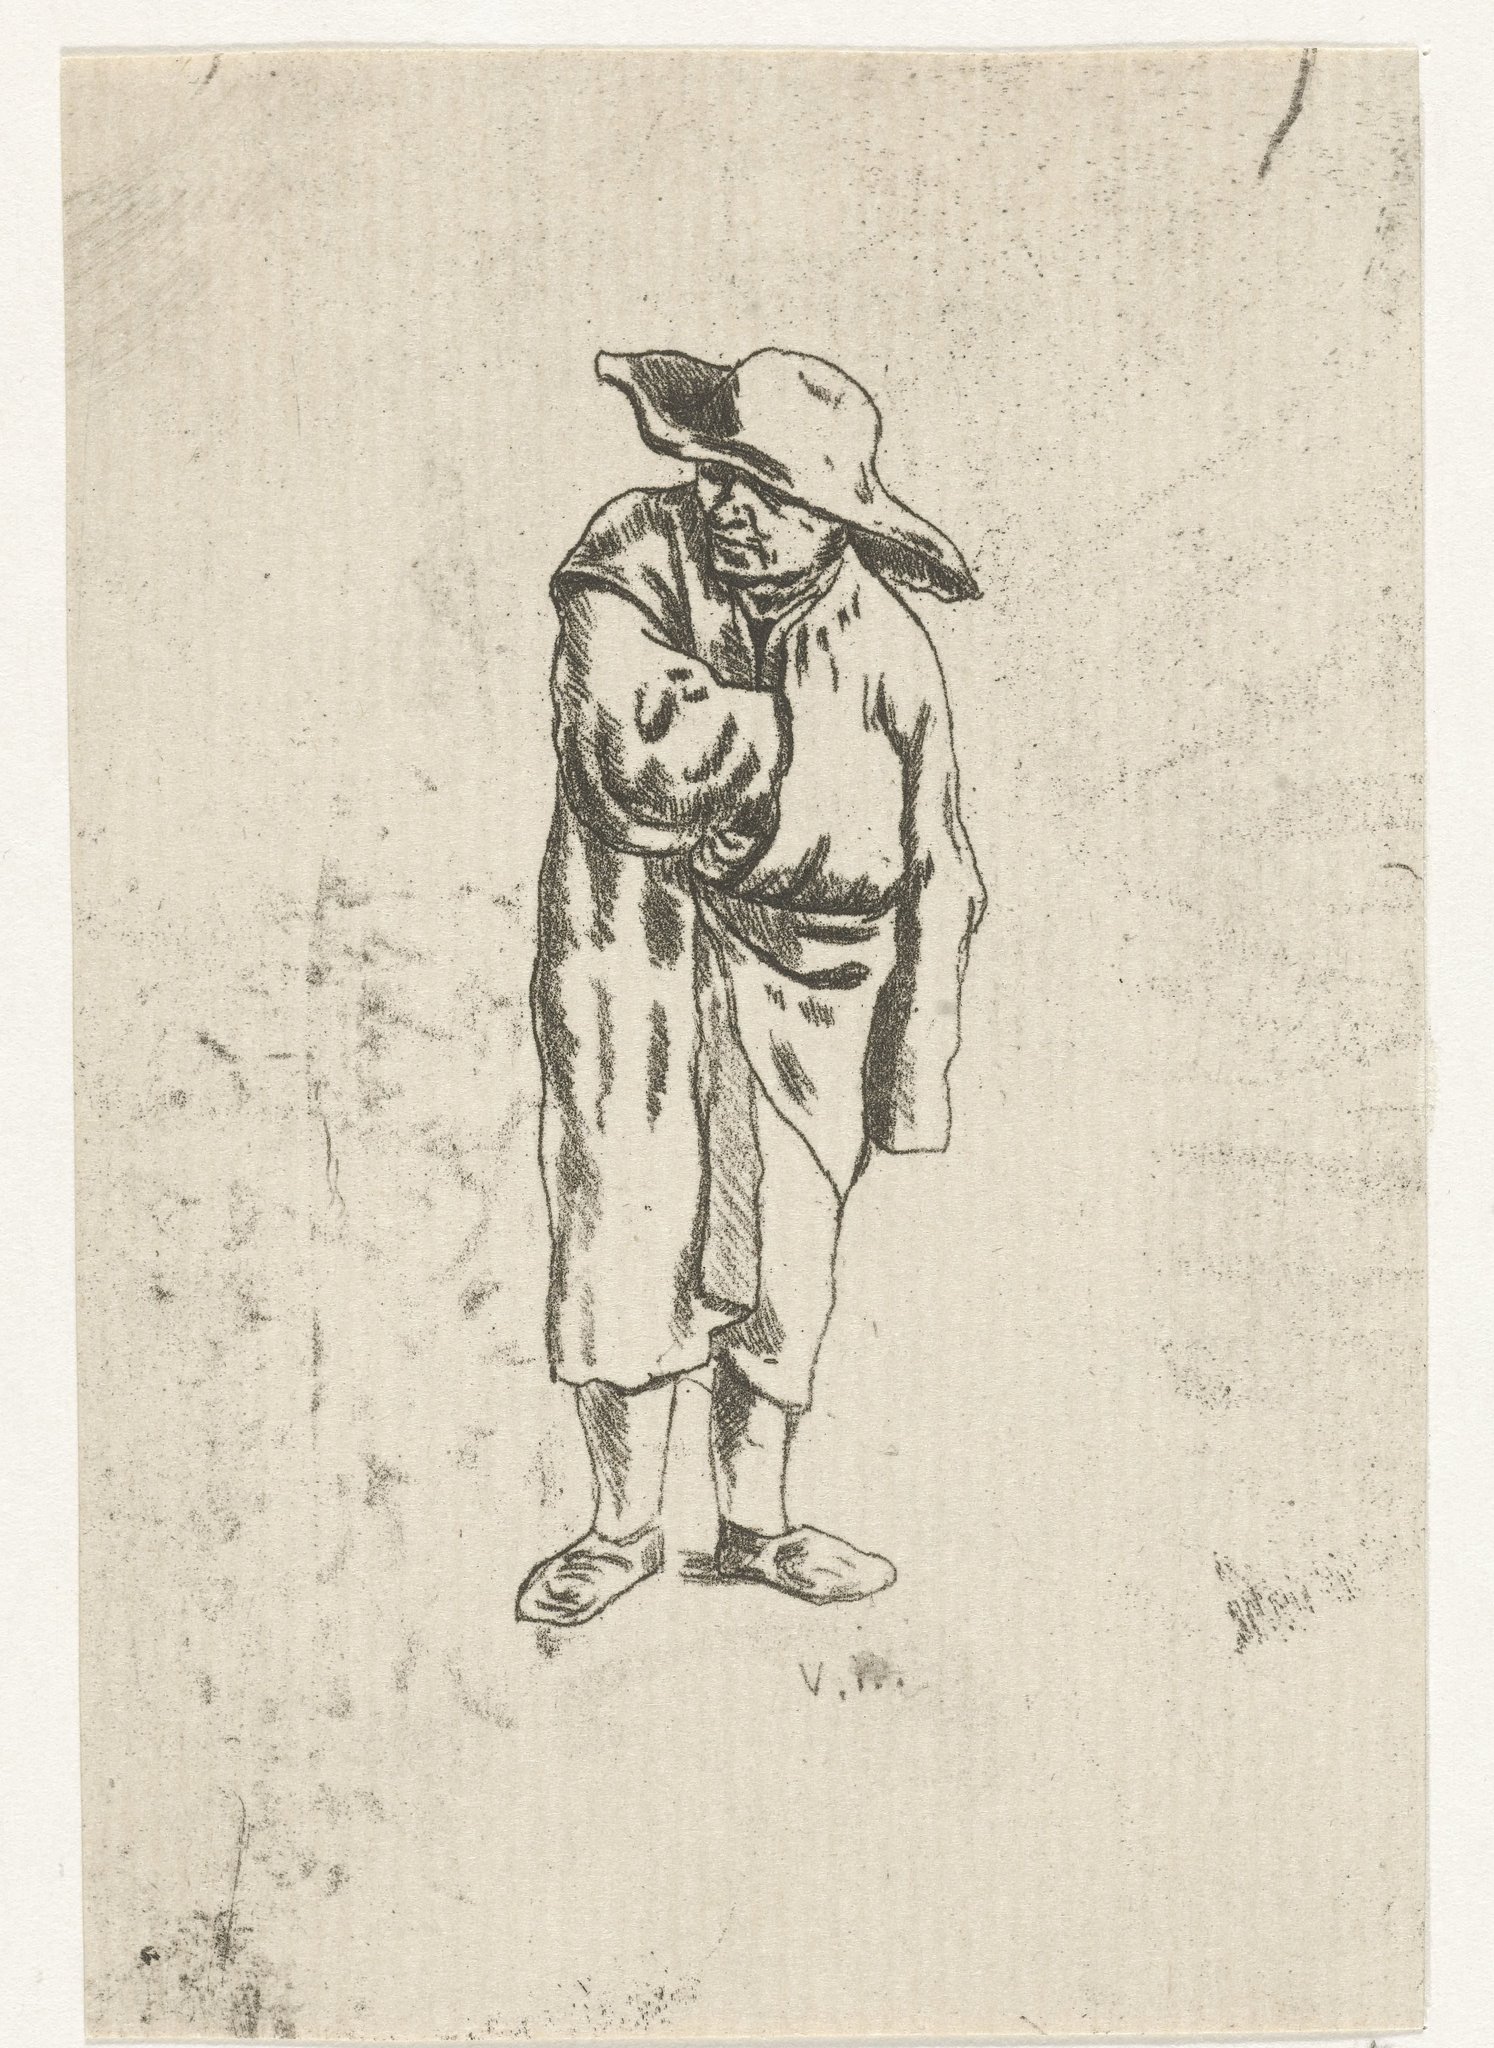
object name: print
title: Man met arm in zijn jas gestoken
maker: nicolaas gerhard van huffel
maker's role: print maker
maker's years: 1869-1936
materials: paper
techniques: soft ground etching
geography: utrecht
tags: adult man, head-gear: hat (+ men's clothes)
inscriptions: collector's mark: Lugt 2228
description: Staande man met rechterarm in zijn jas gestoken. Hij draagt een hoed.